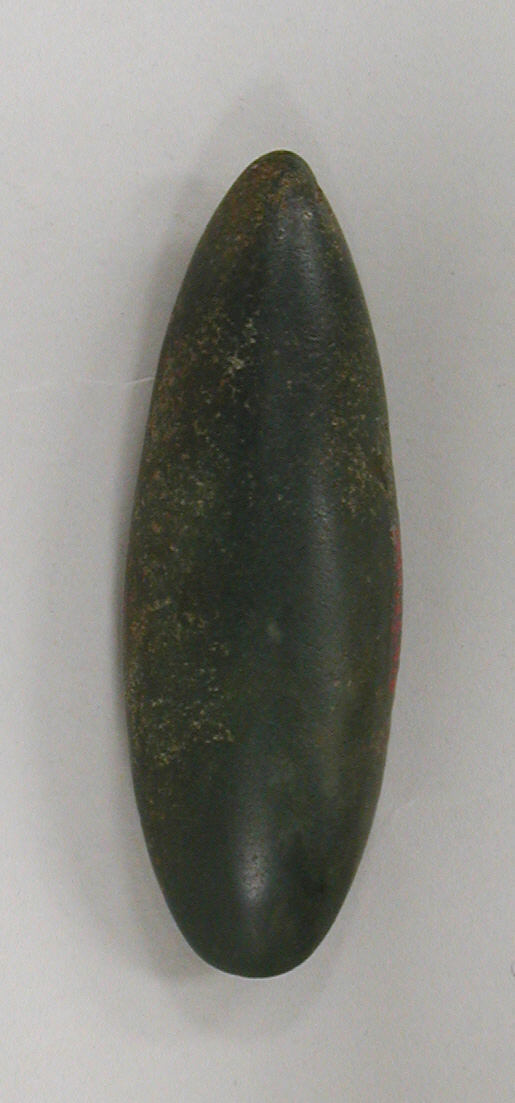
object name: celt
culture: taíno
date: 901-1500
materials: stone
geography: dominican republic